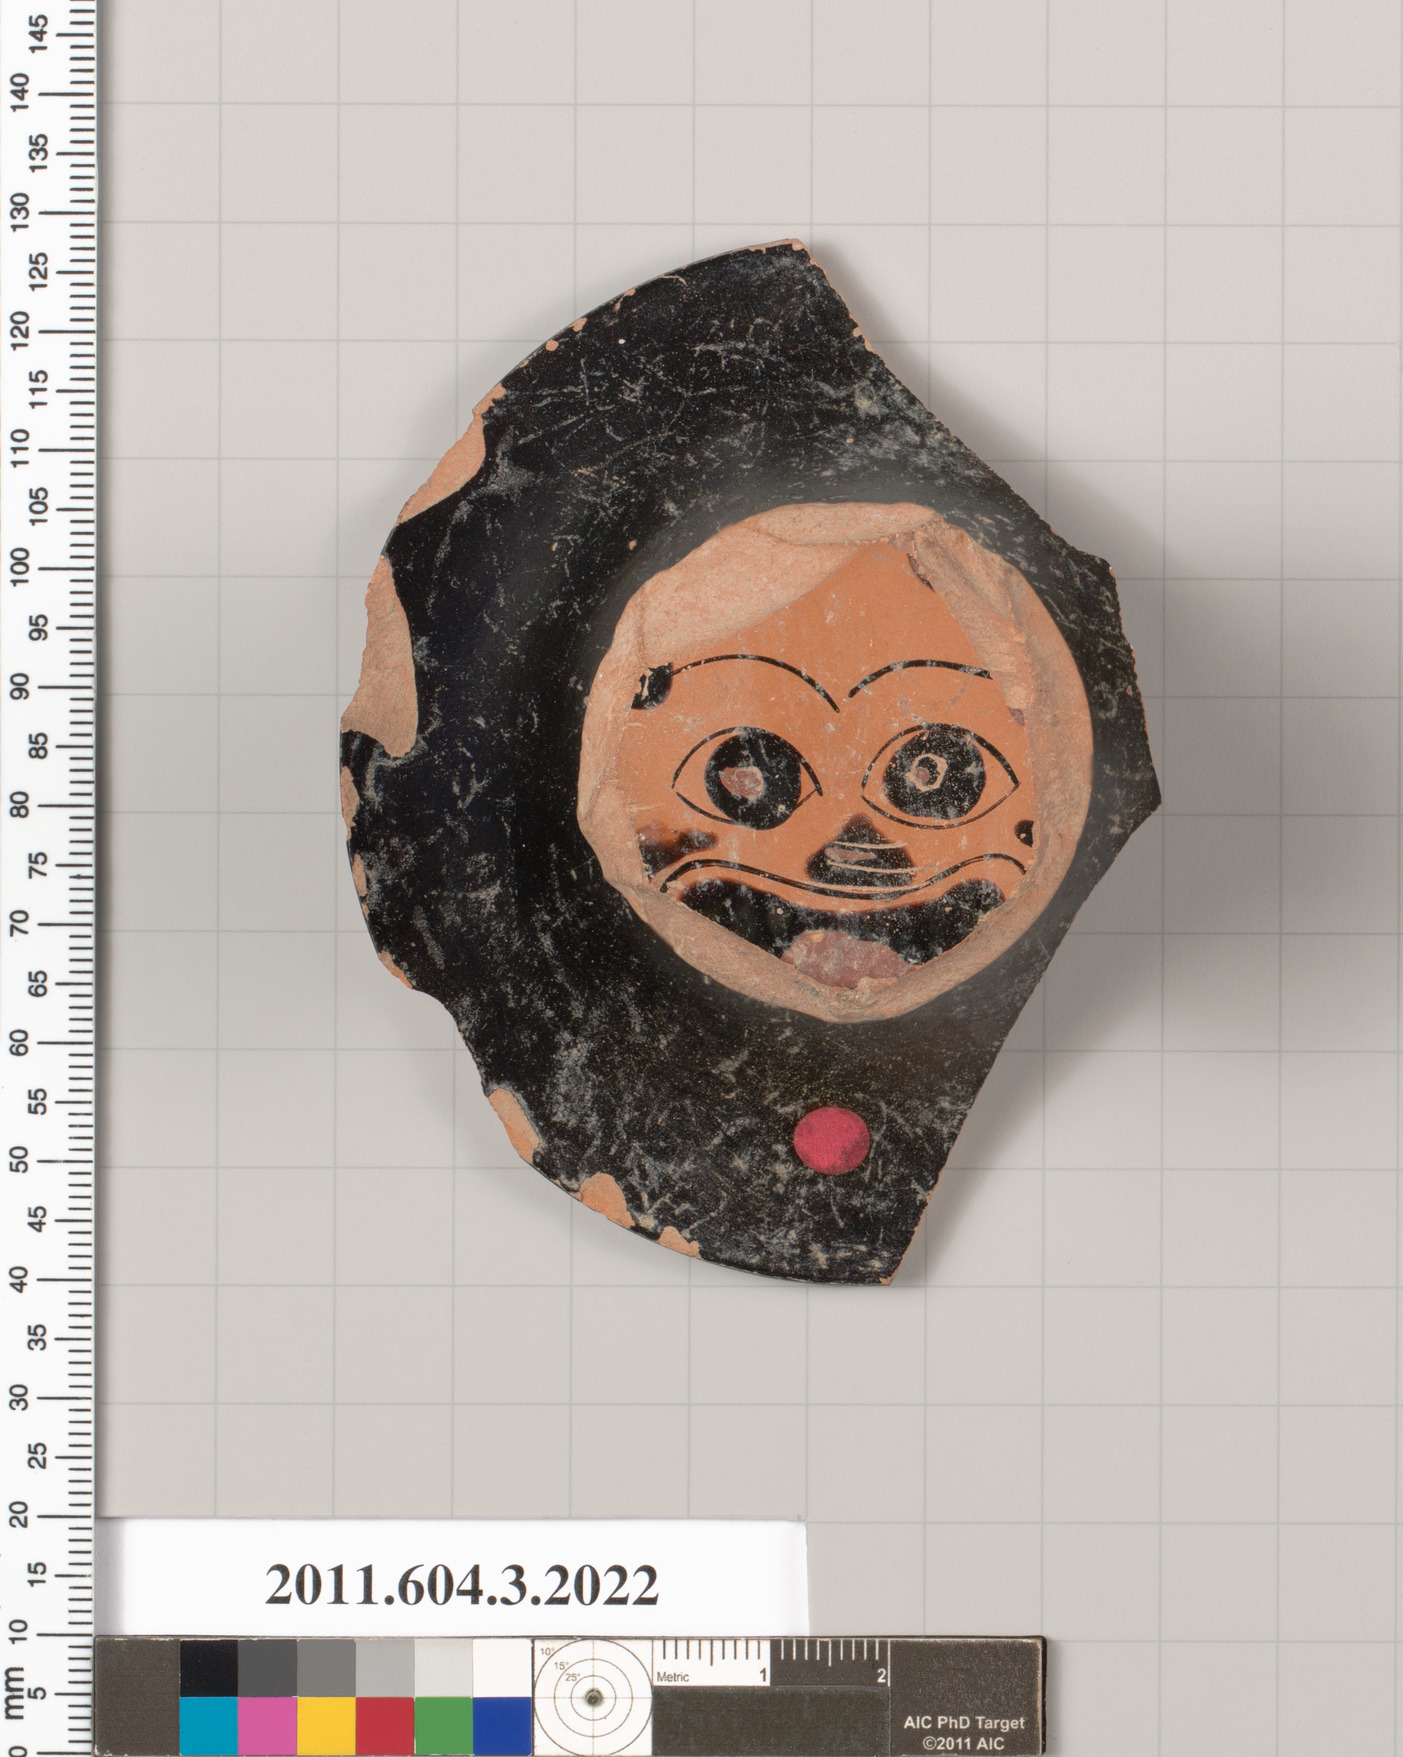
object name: kylix fragment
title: Terracotta fragment of a kylix (drinking cup)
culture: greek, attic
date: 550-526 BCE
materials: terracotta